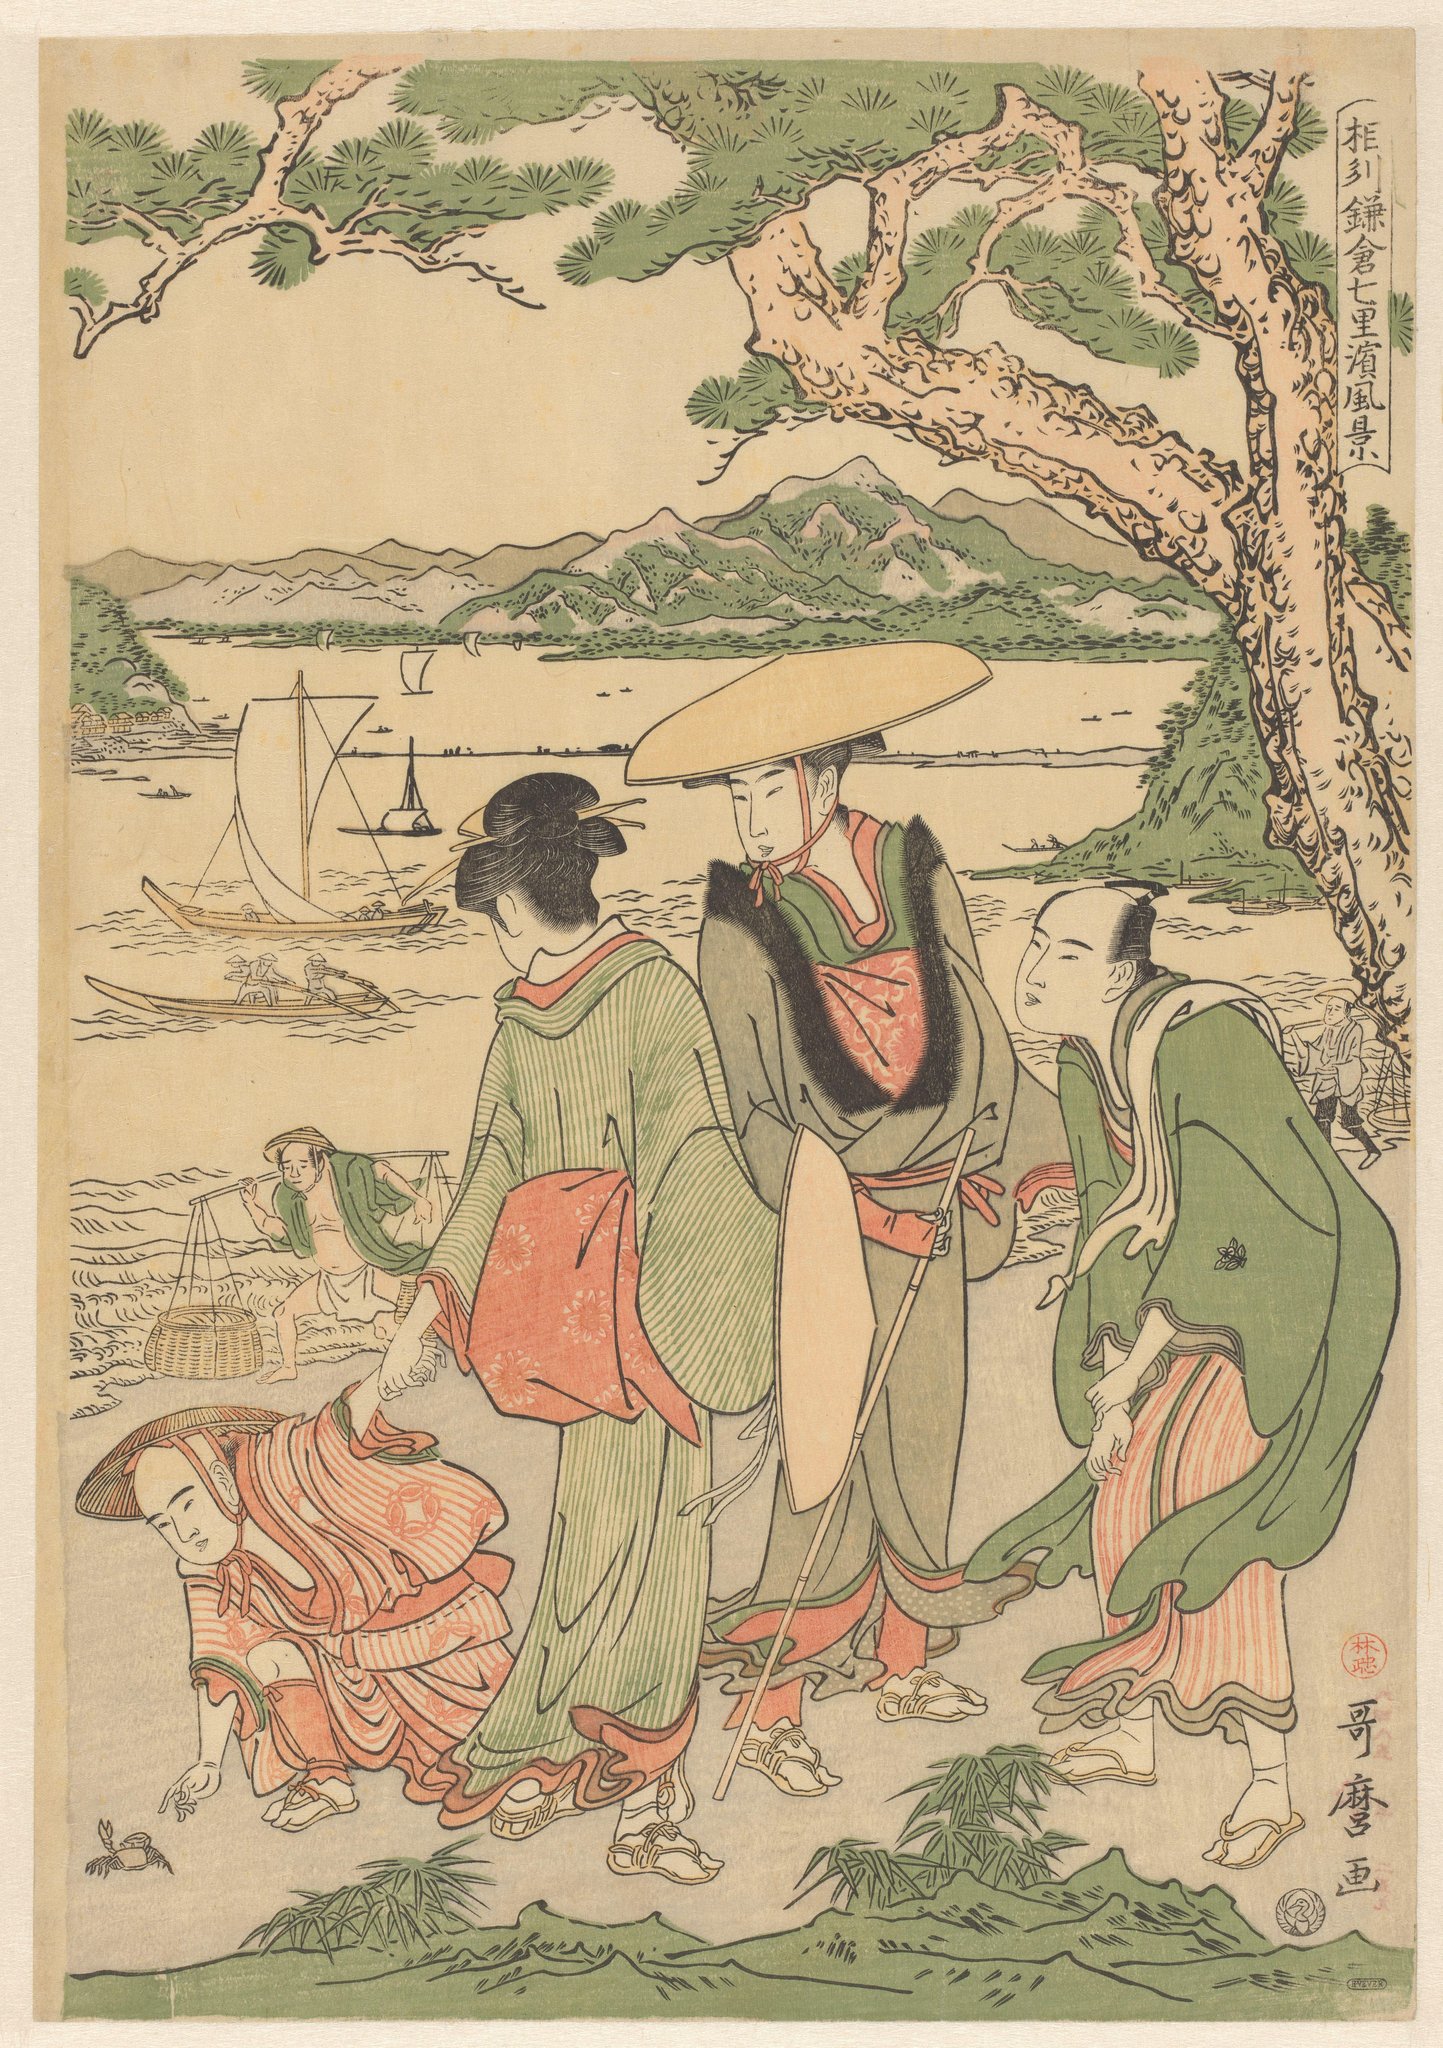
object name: print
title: Gezicht op het Shichirigahama strand in Kamakura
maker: kitagawa utamaro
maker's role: print maker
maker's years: 1753-1806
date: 1788-1790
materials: paper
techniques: woodcut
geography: japan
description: Een man, twee vrouwen en een kind op het strand. Het kind bukt naar een krabbetje. Langs de waterlijn lopen mandendragers en op het water verschillende boten. (rechter blad van een drieluik)